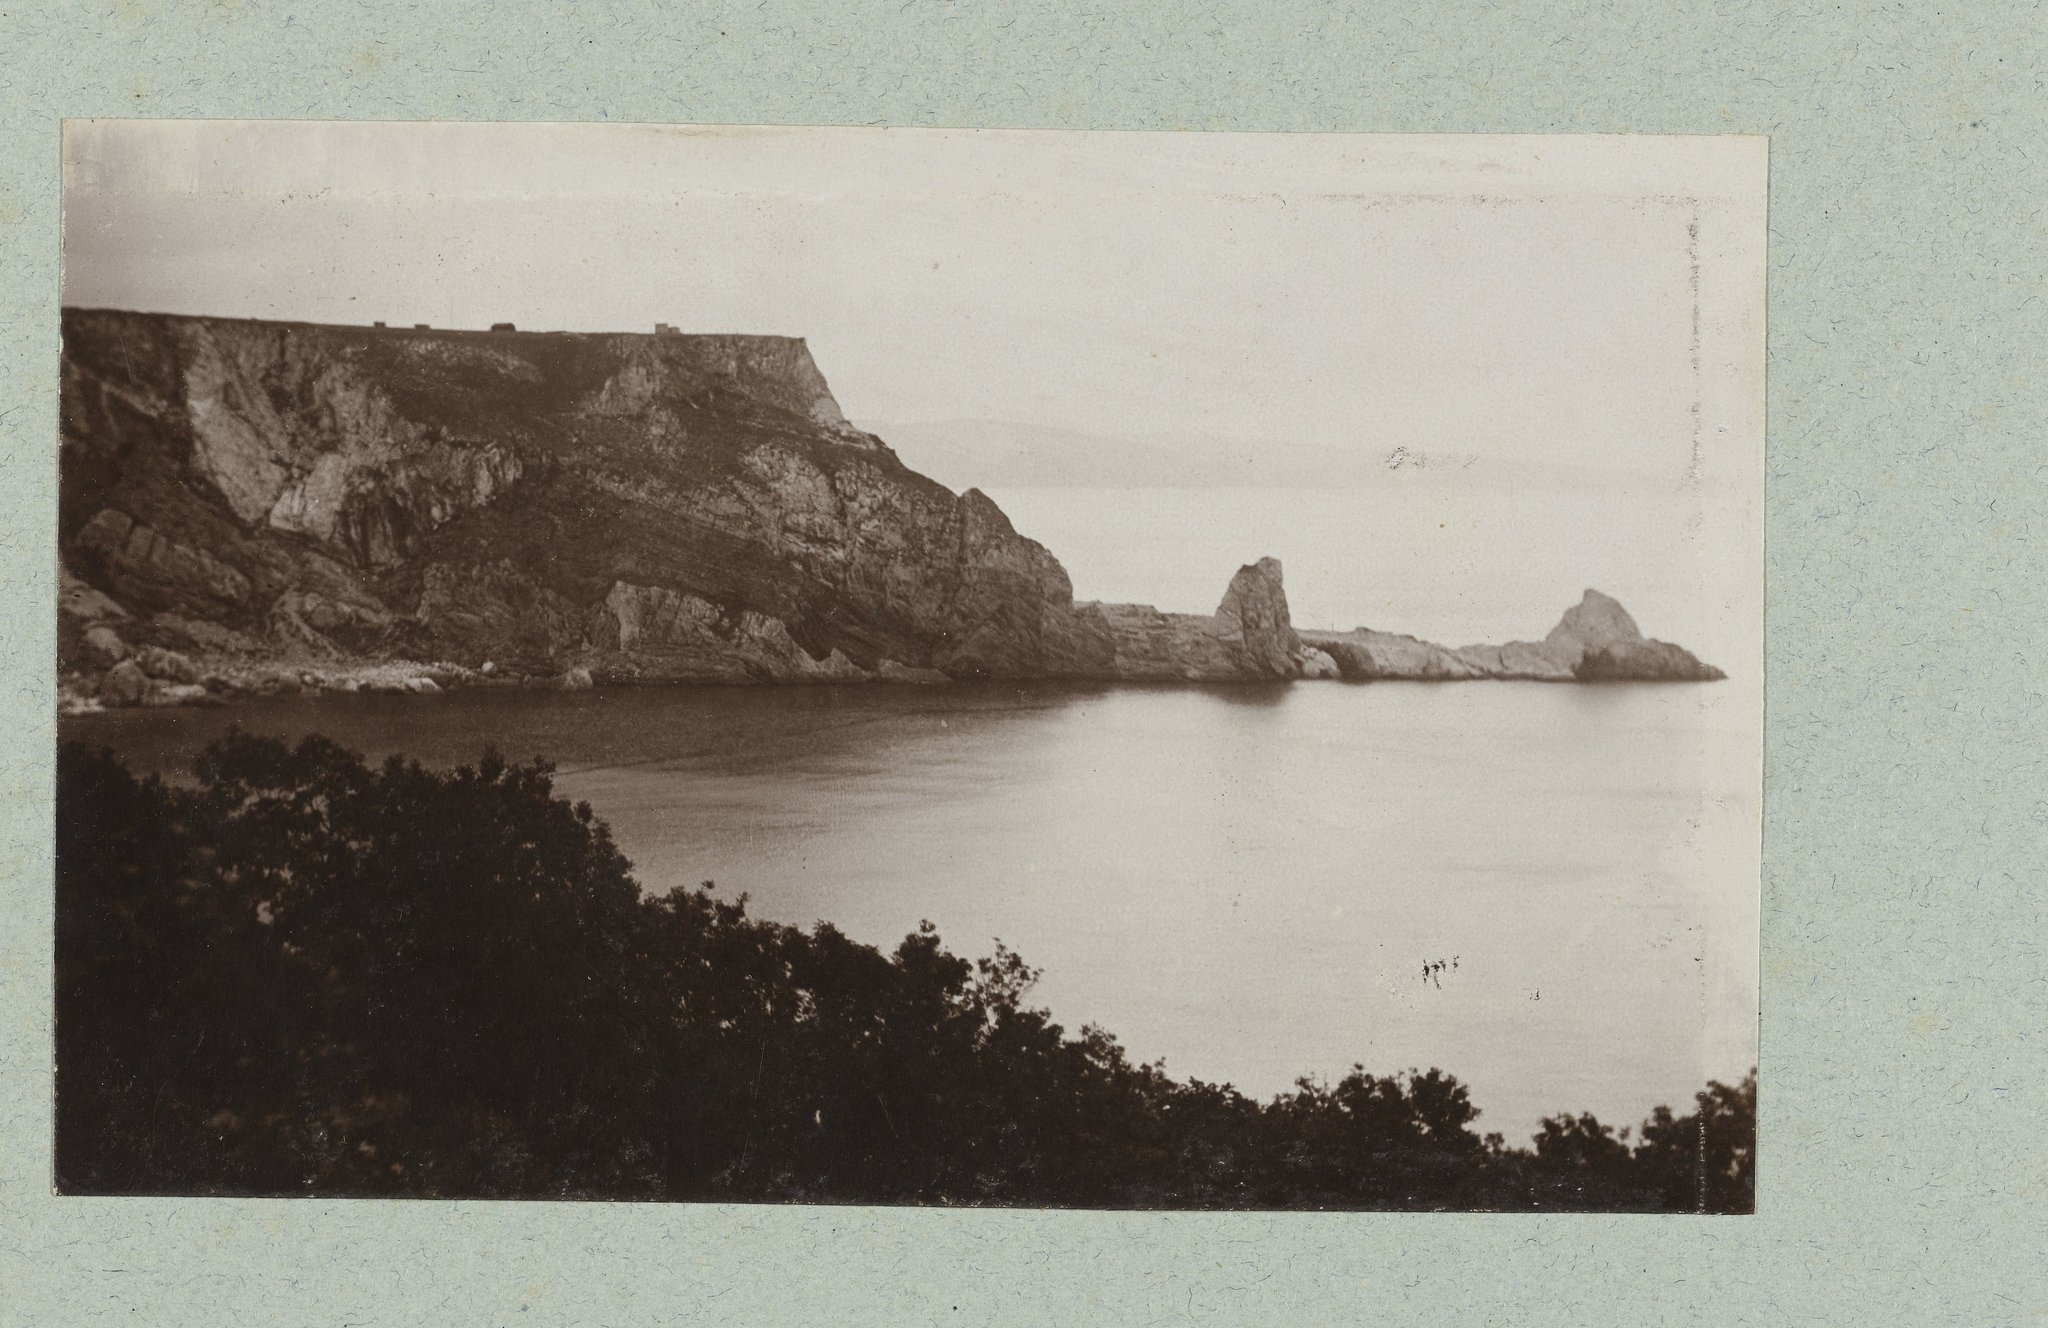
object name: photograph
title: The nose near Torquay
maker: frits freerks fontein fz.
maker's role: fotograaf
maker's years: 1882-1928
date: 1901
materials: cardboard, paper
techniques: gelatin silver print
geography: netherlands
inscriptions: caption: ‘The nose near Torquay’